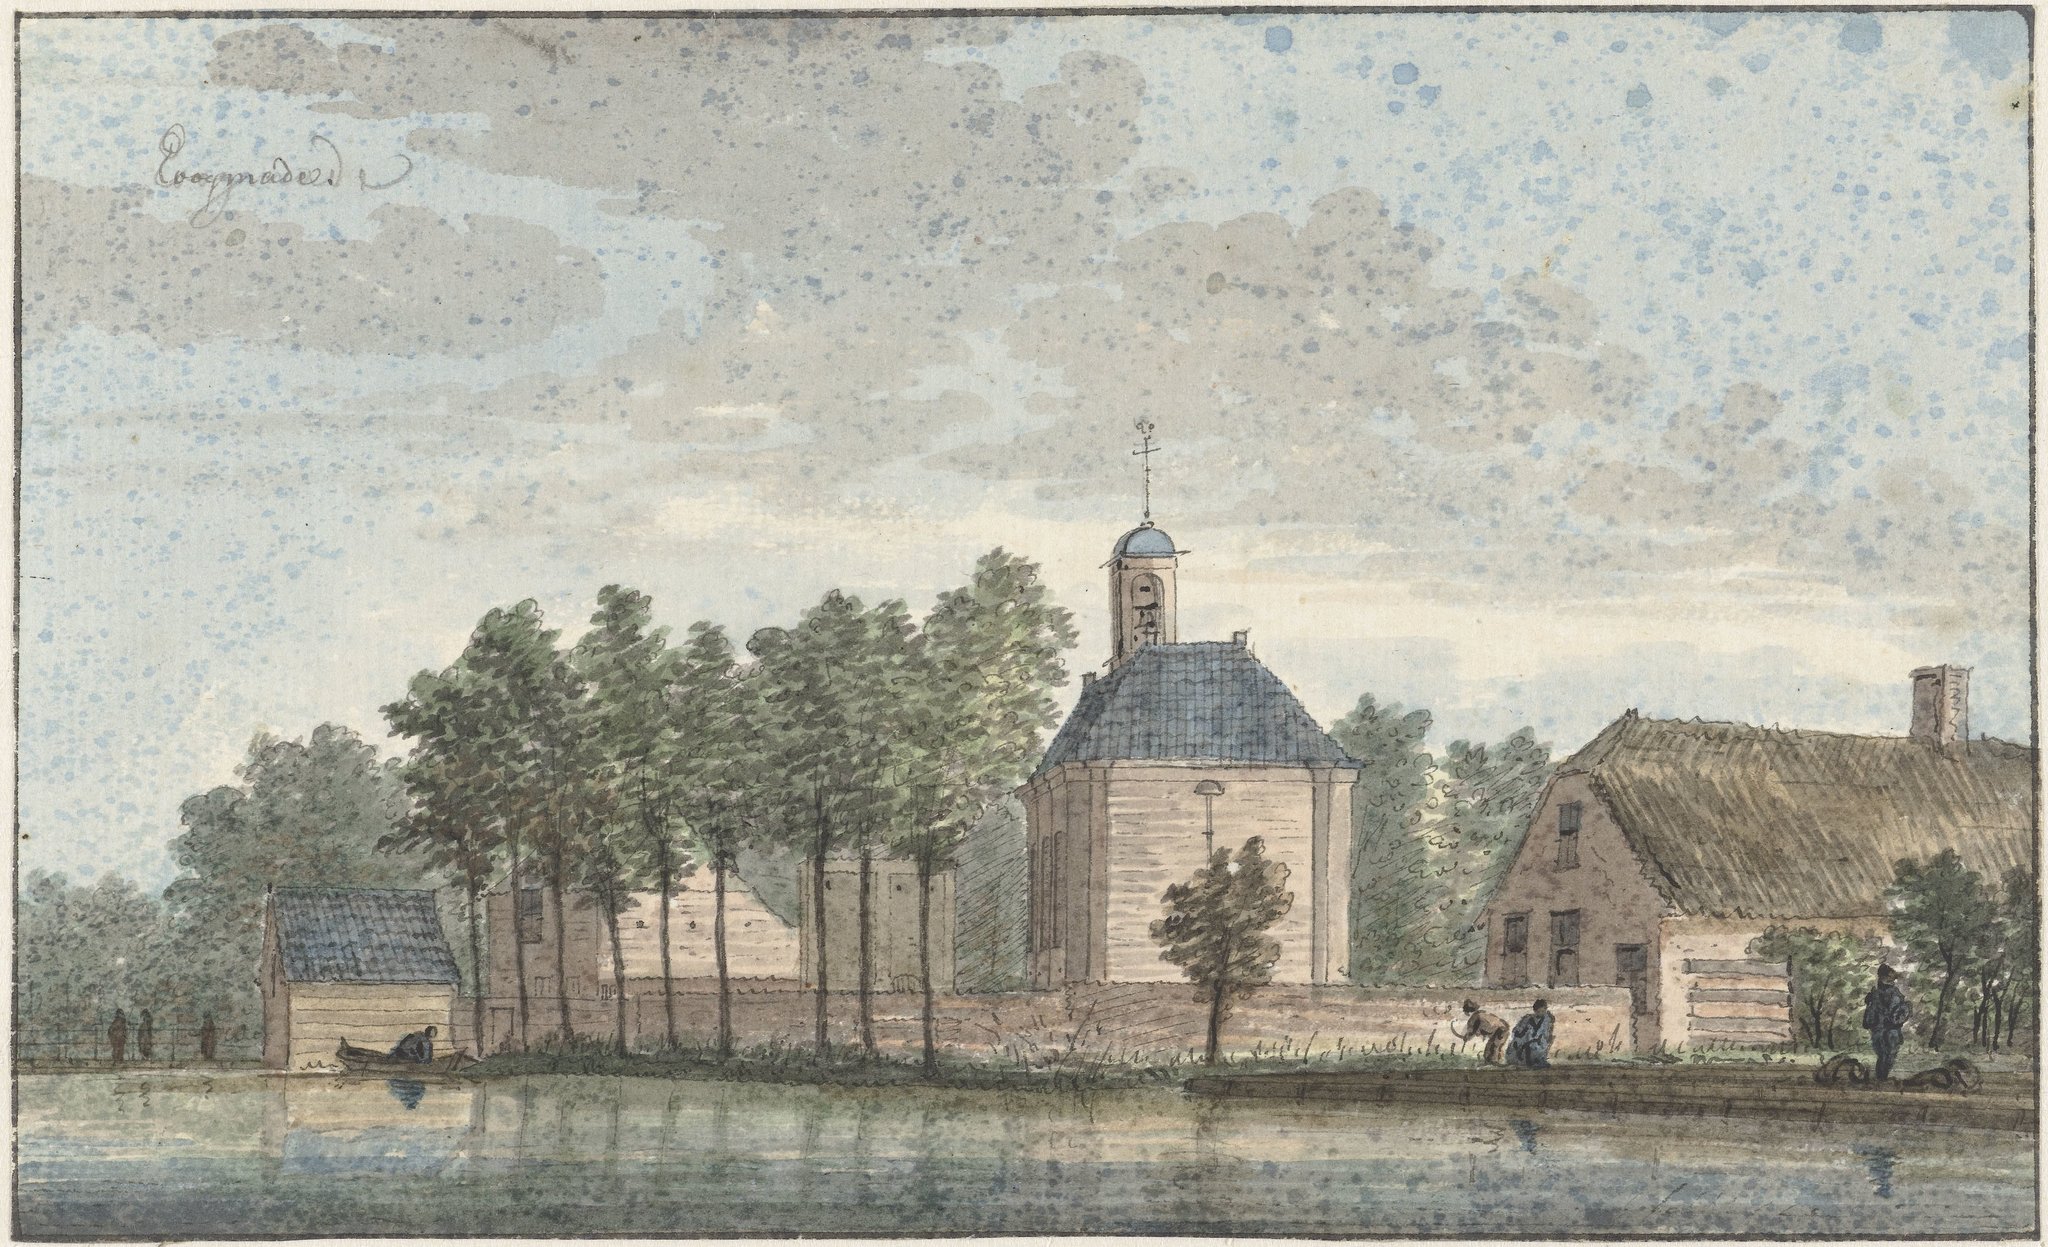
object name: drawing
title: Het dorp Hoogmade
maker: cornelis pronk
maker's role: draughtsman, painter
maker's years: 1691-1759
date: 1730-1740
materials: ink, paper, watercolor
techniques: brush, pen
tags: prospect of village, silhouette of village, church (exterior)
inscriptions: inscription: ‘hoogmade’